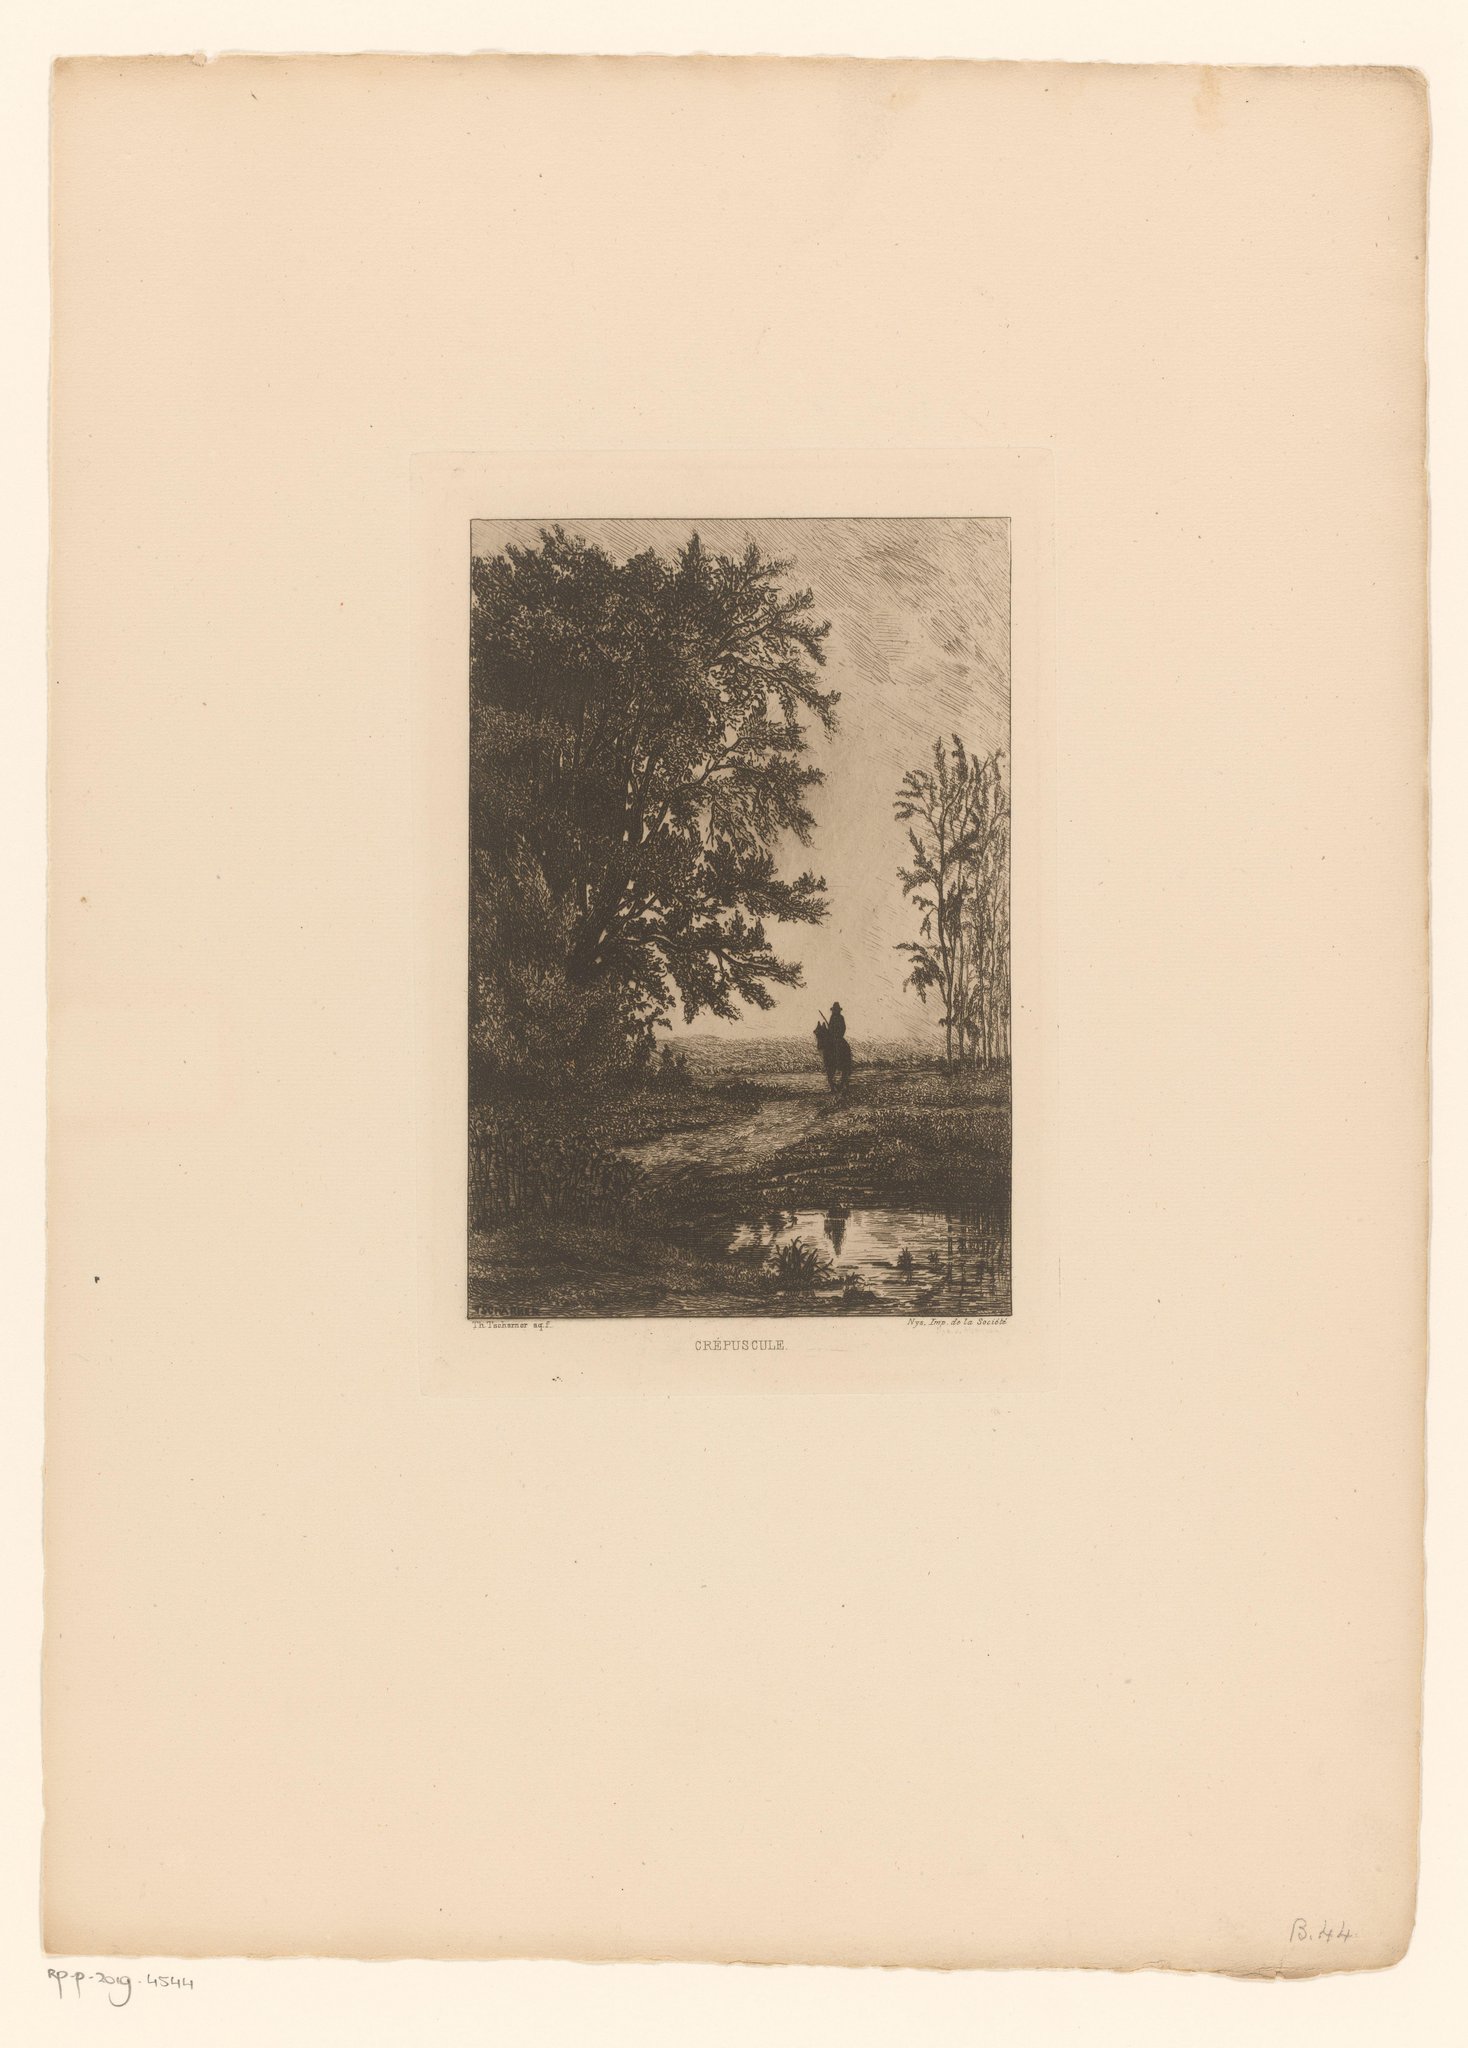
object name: print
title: Crépuscule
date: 1875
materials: paper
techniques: etching, intaglio, retroussage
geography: brussels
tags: riding a horse, ass, or mule; rider, horseman, brook, forest path or lane